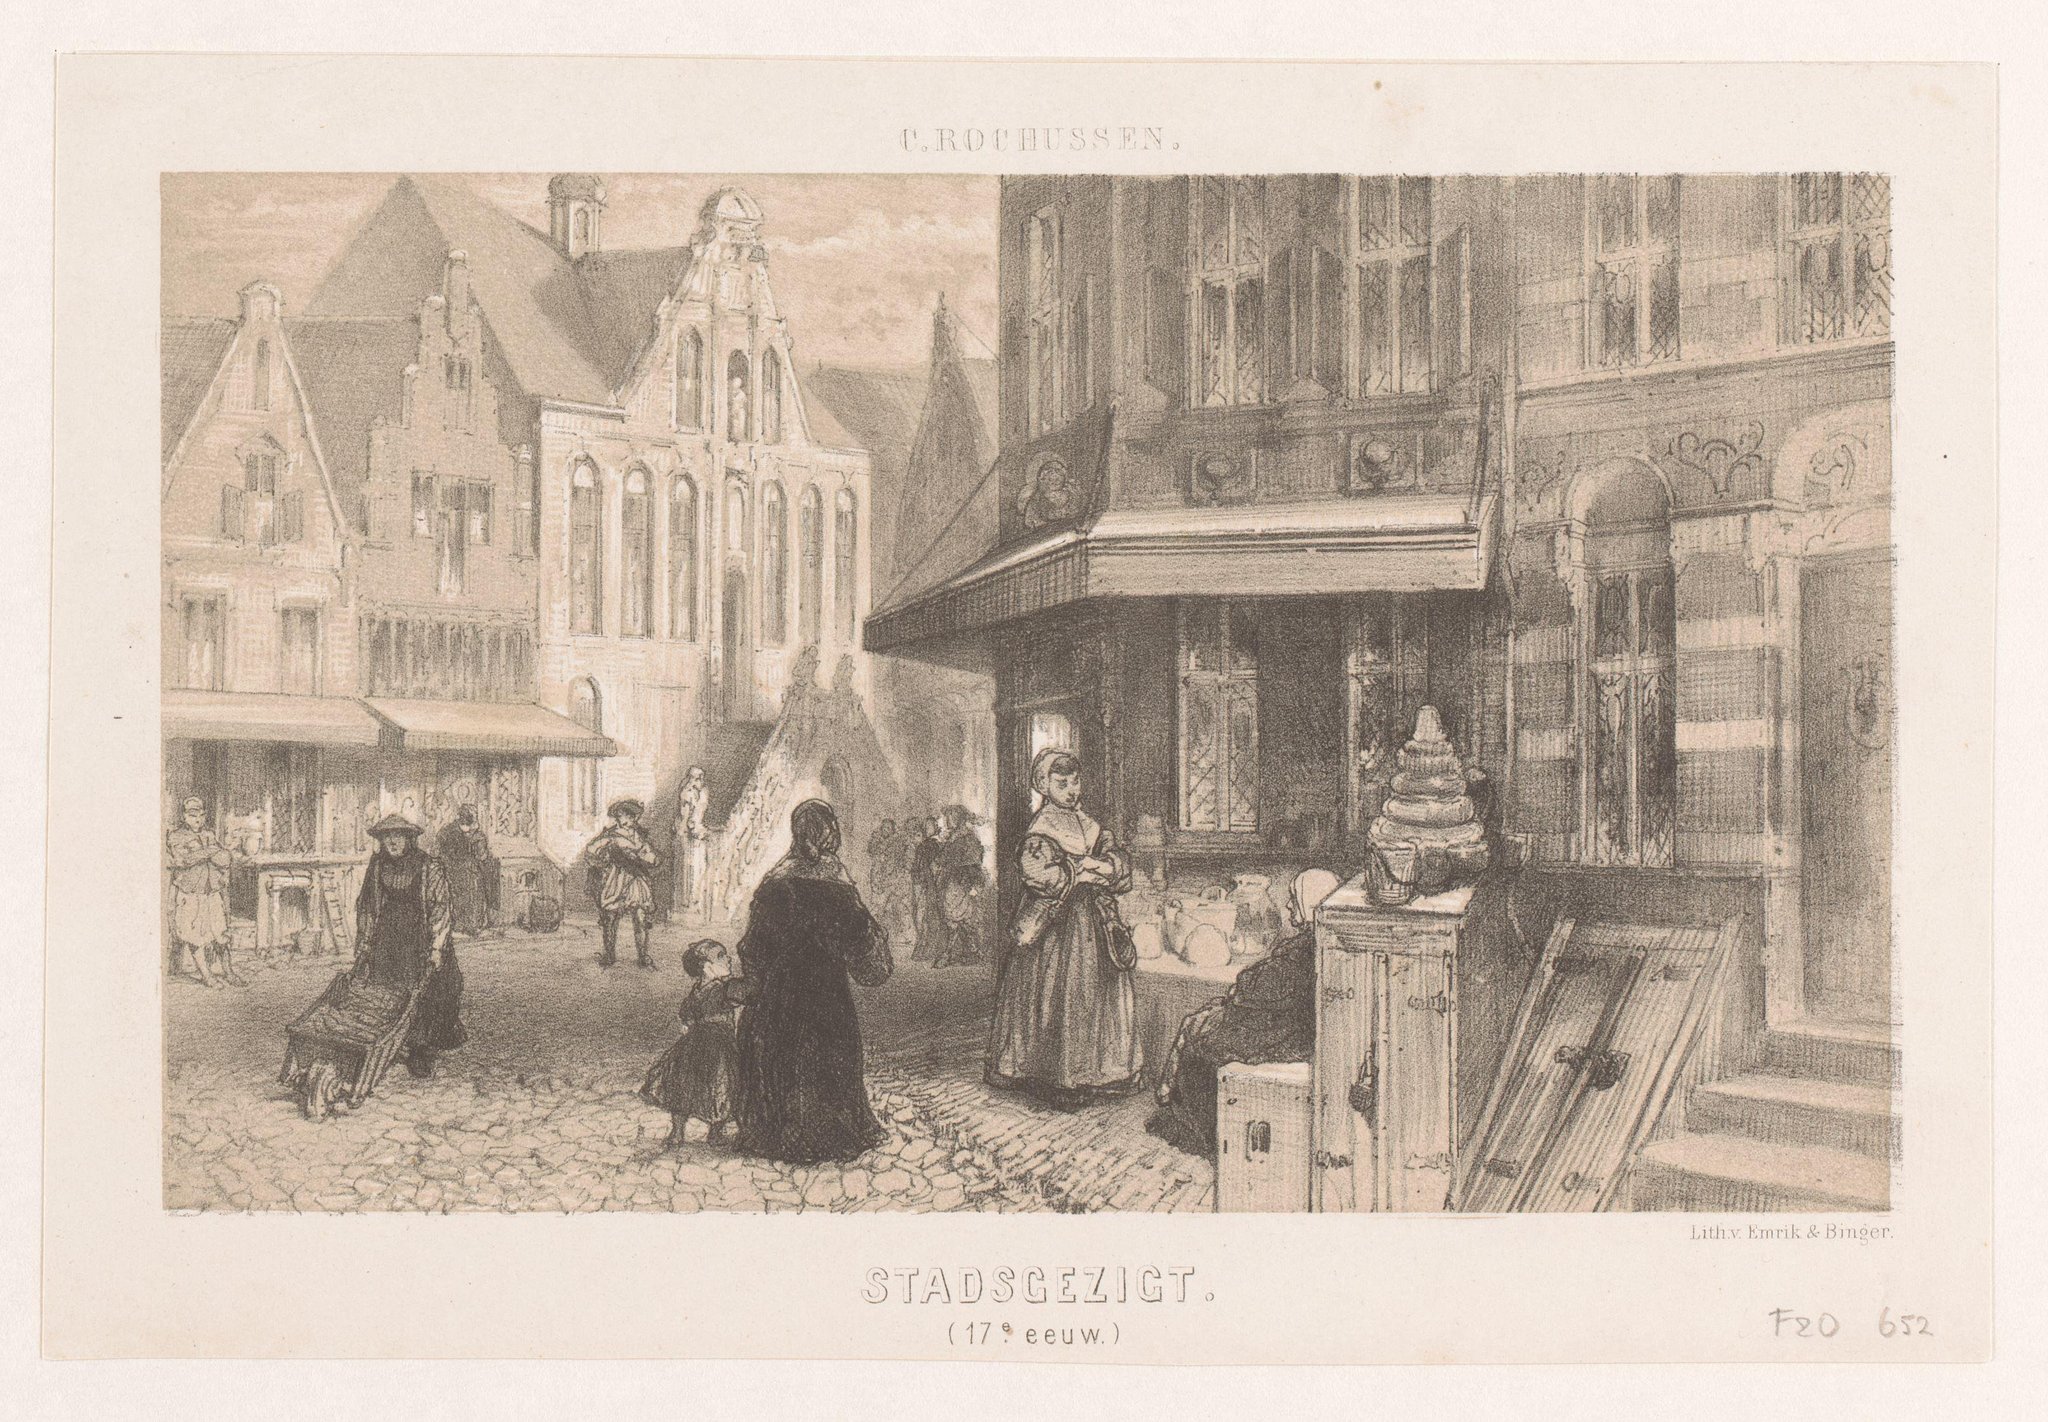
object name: print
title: Stadsgezicht (17e eeuw)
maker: arie cornelis kruseman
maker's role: bookseller, printer, publisher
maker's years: 1818-1894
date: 1867-1868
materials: paper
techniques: tone lithography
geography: haarlem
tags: city-view in general; 'veduta'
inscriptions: collector's mark: Lugt 2228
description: Prent uit: Schotel, Gillis Dyonisius Jacobus. Het Oud-Hollandsch huisgezin. Haarlem: Kruseman, Arie Cornelis, 1867-1868.